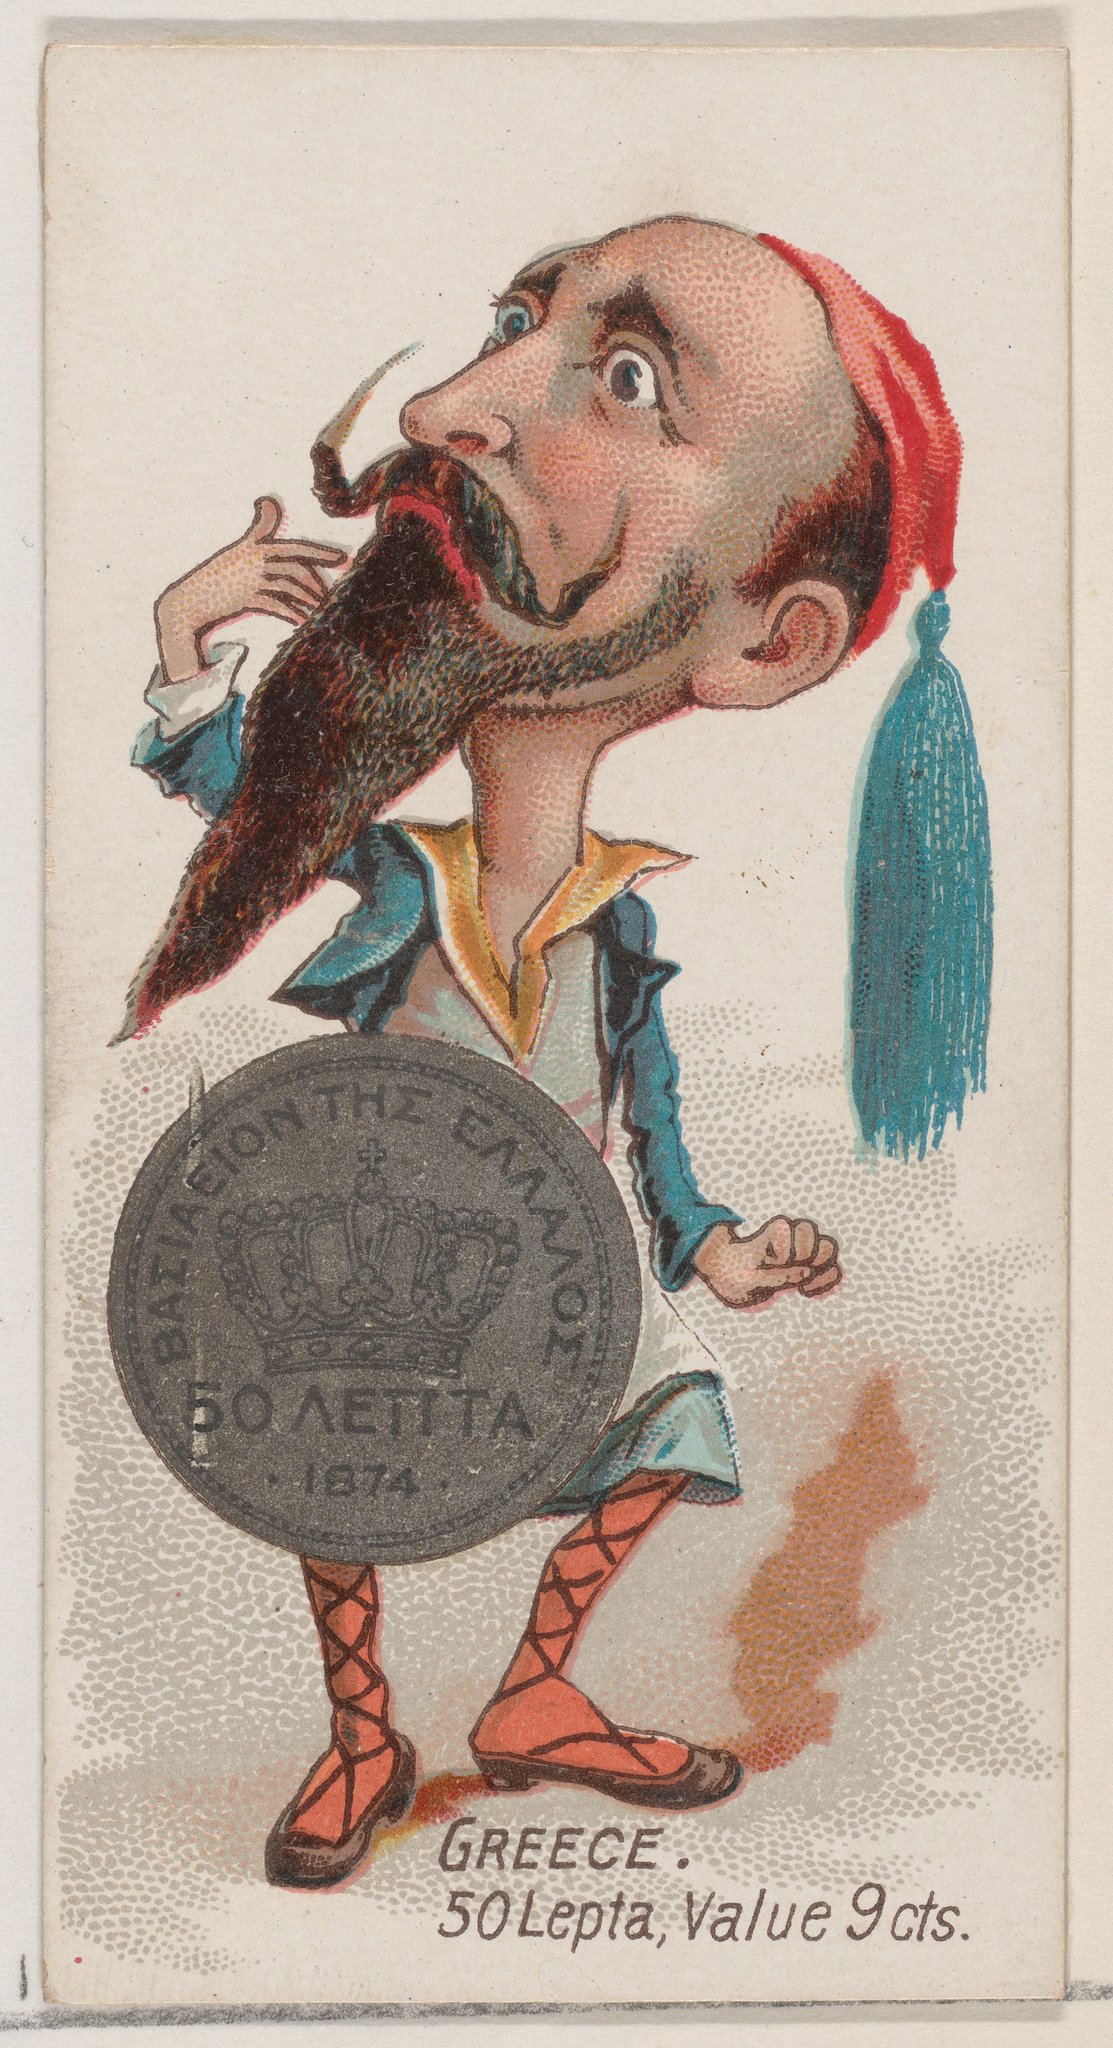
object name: print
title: Caricatured Greek figure, 50 Lepta, from the series Coins of All Nations (N72, variation 1) for Duke brand cigarettes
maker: w. duke, sons & co.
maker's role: publisher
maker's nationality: american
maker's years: 1870-1920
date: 1889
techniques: color lithograph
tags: men,coins